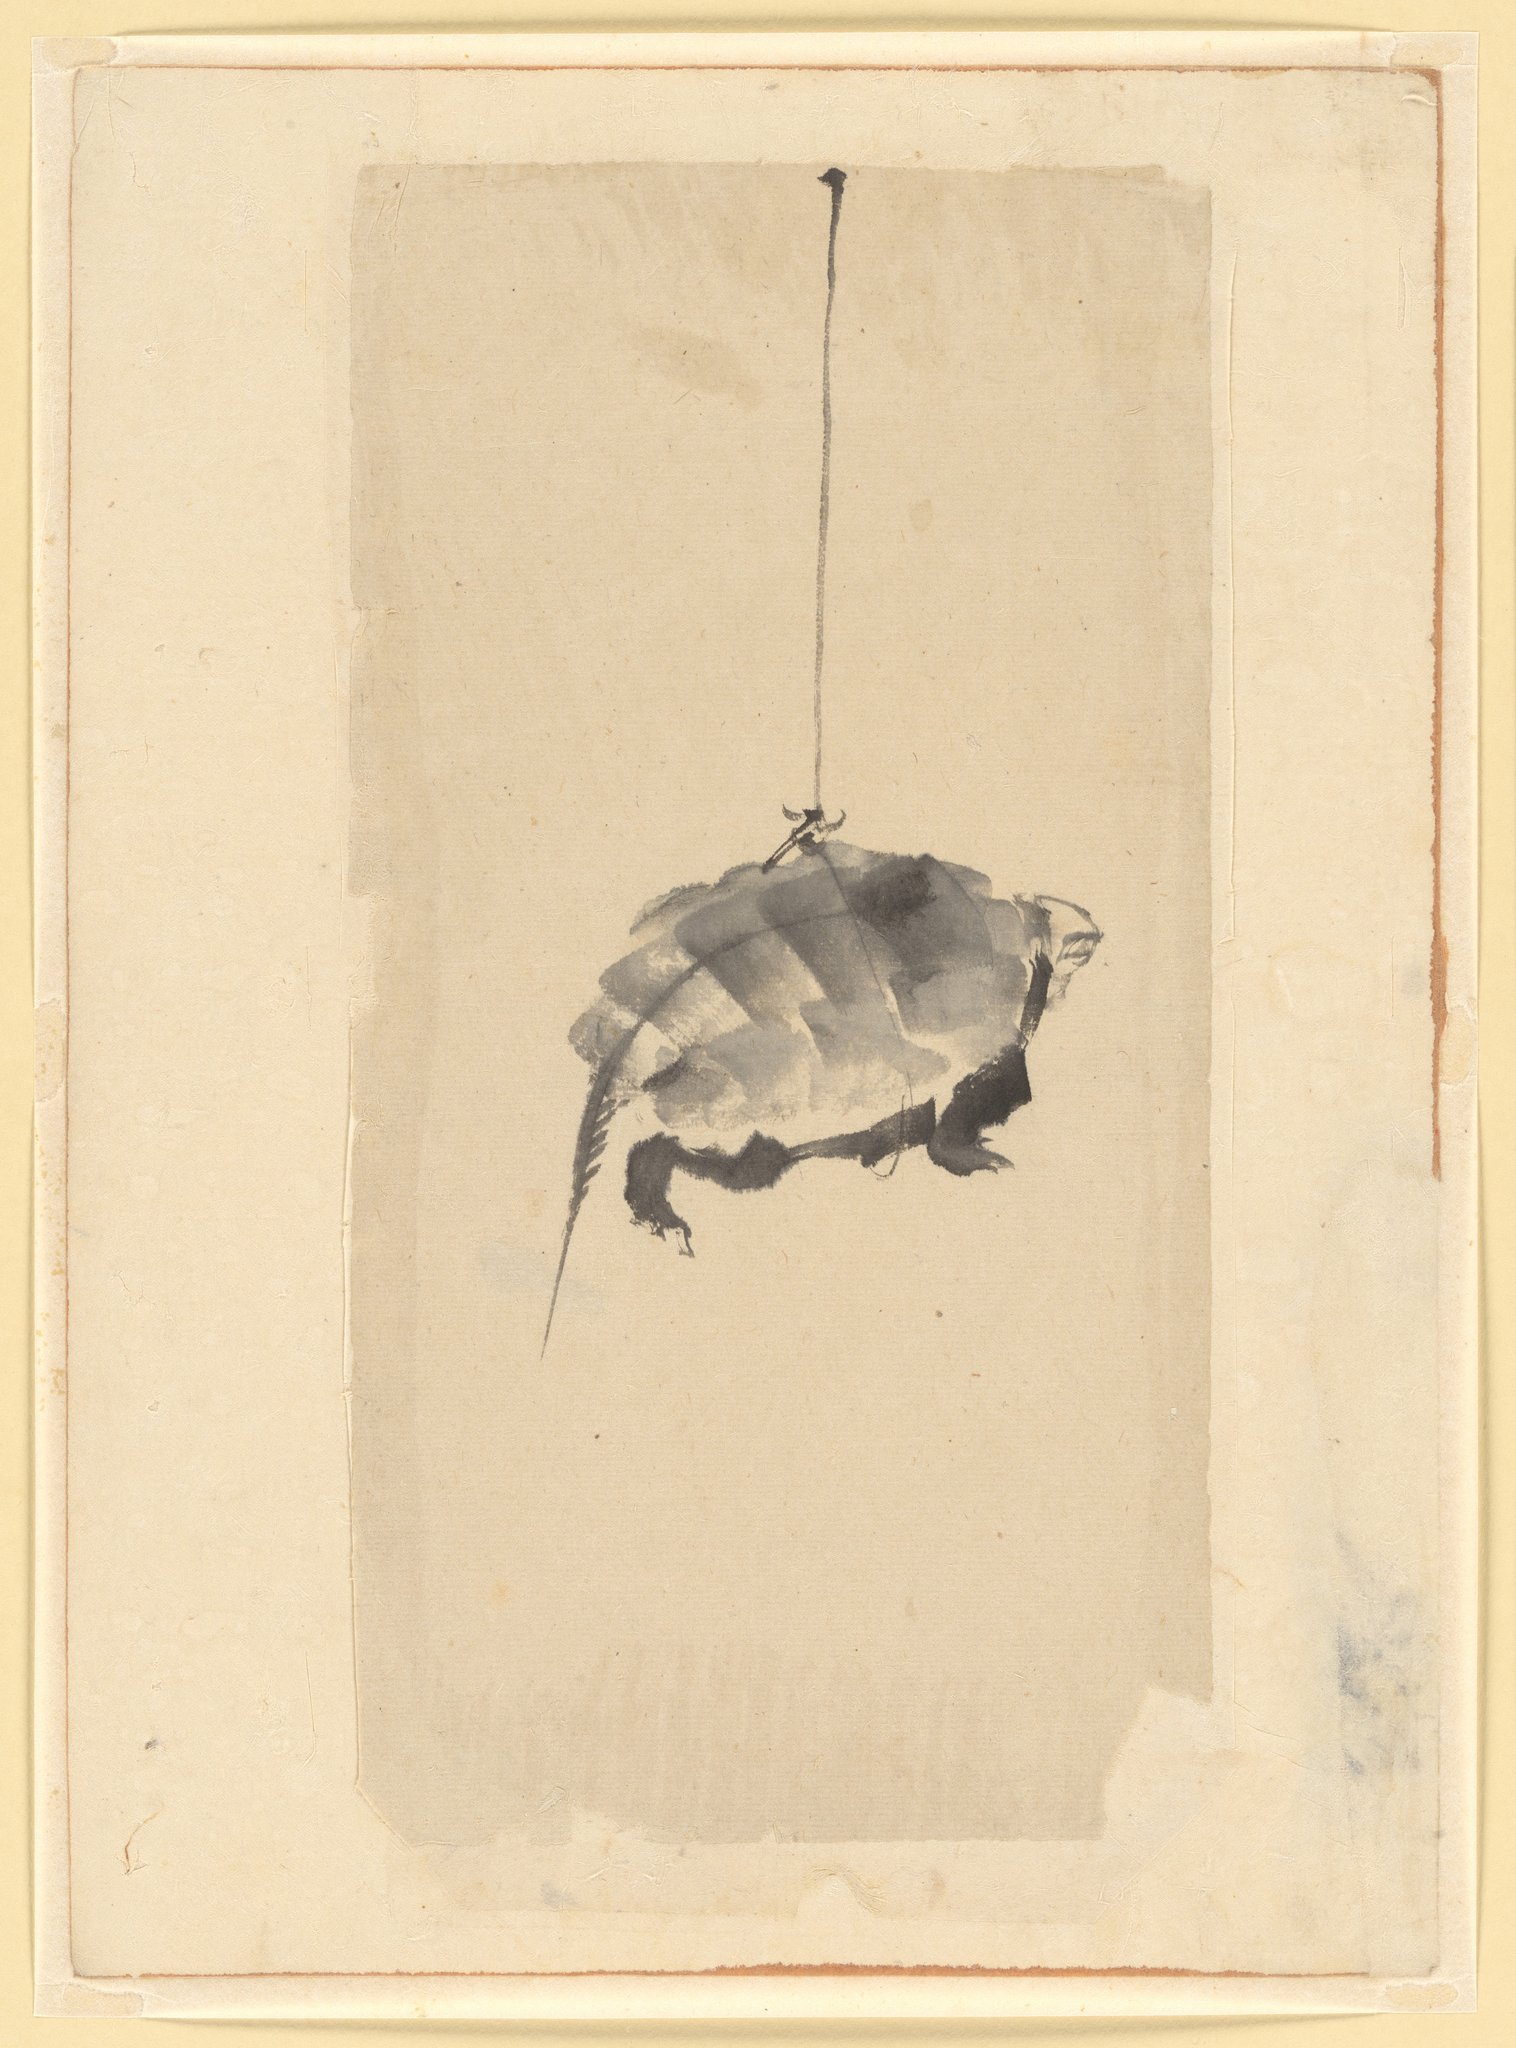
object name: drawing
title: Tortoise Suspended By String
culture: japanese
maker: katsushika hokusai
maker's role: artist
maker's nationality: japanese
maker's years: 1760-1849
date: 1701-1900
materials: ink, paper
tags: animals